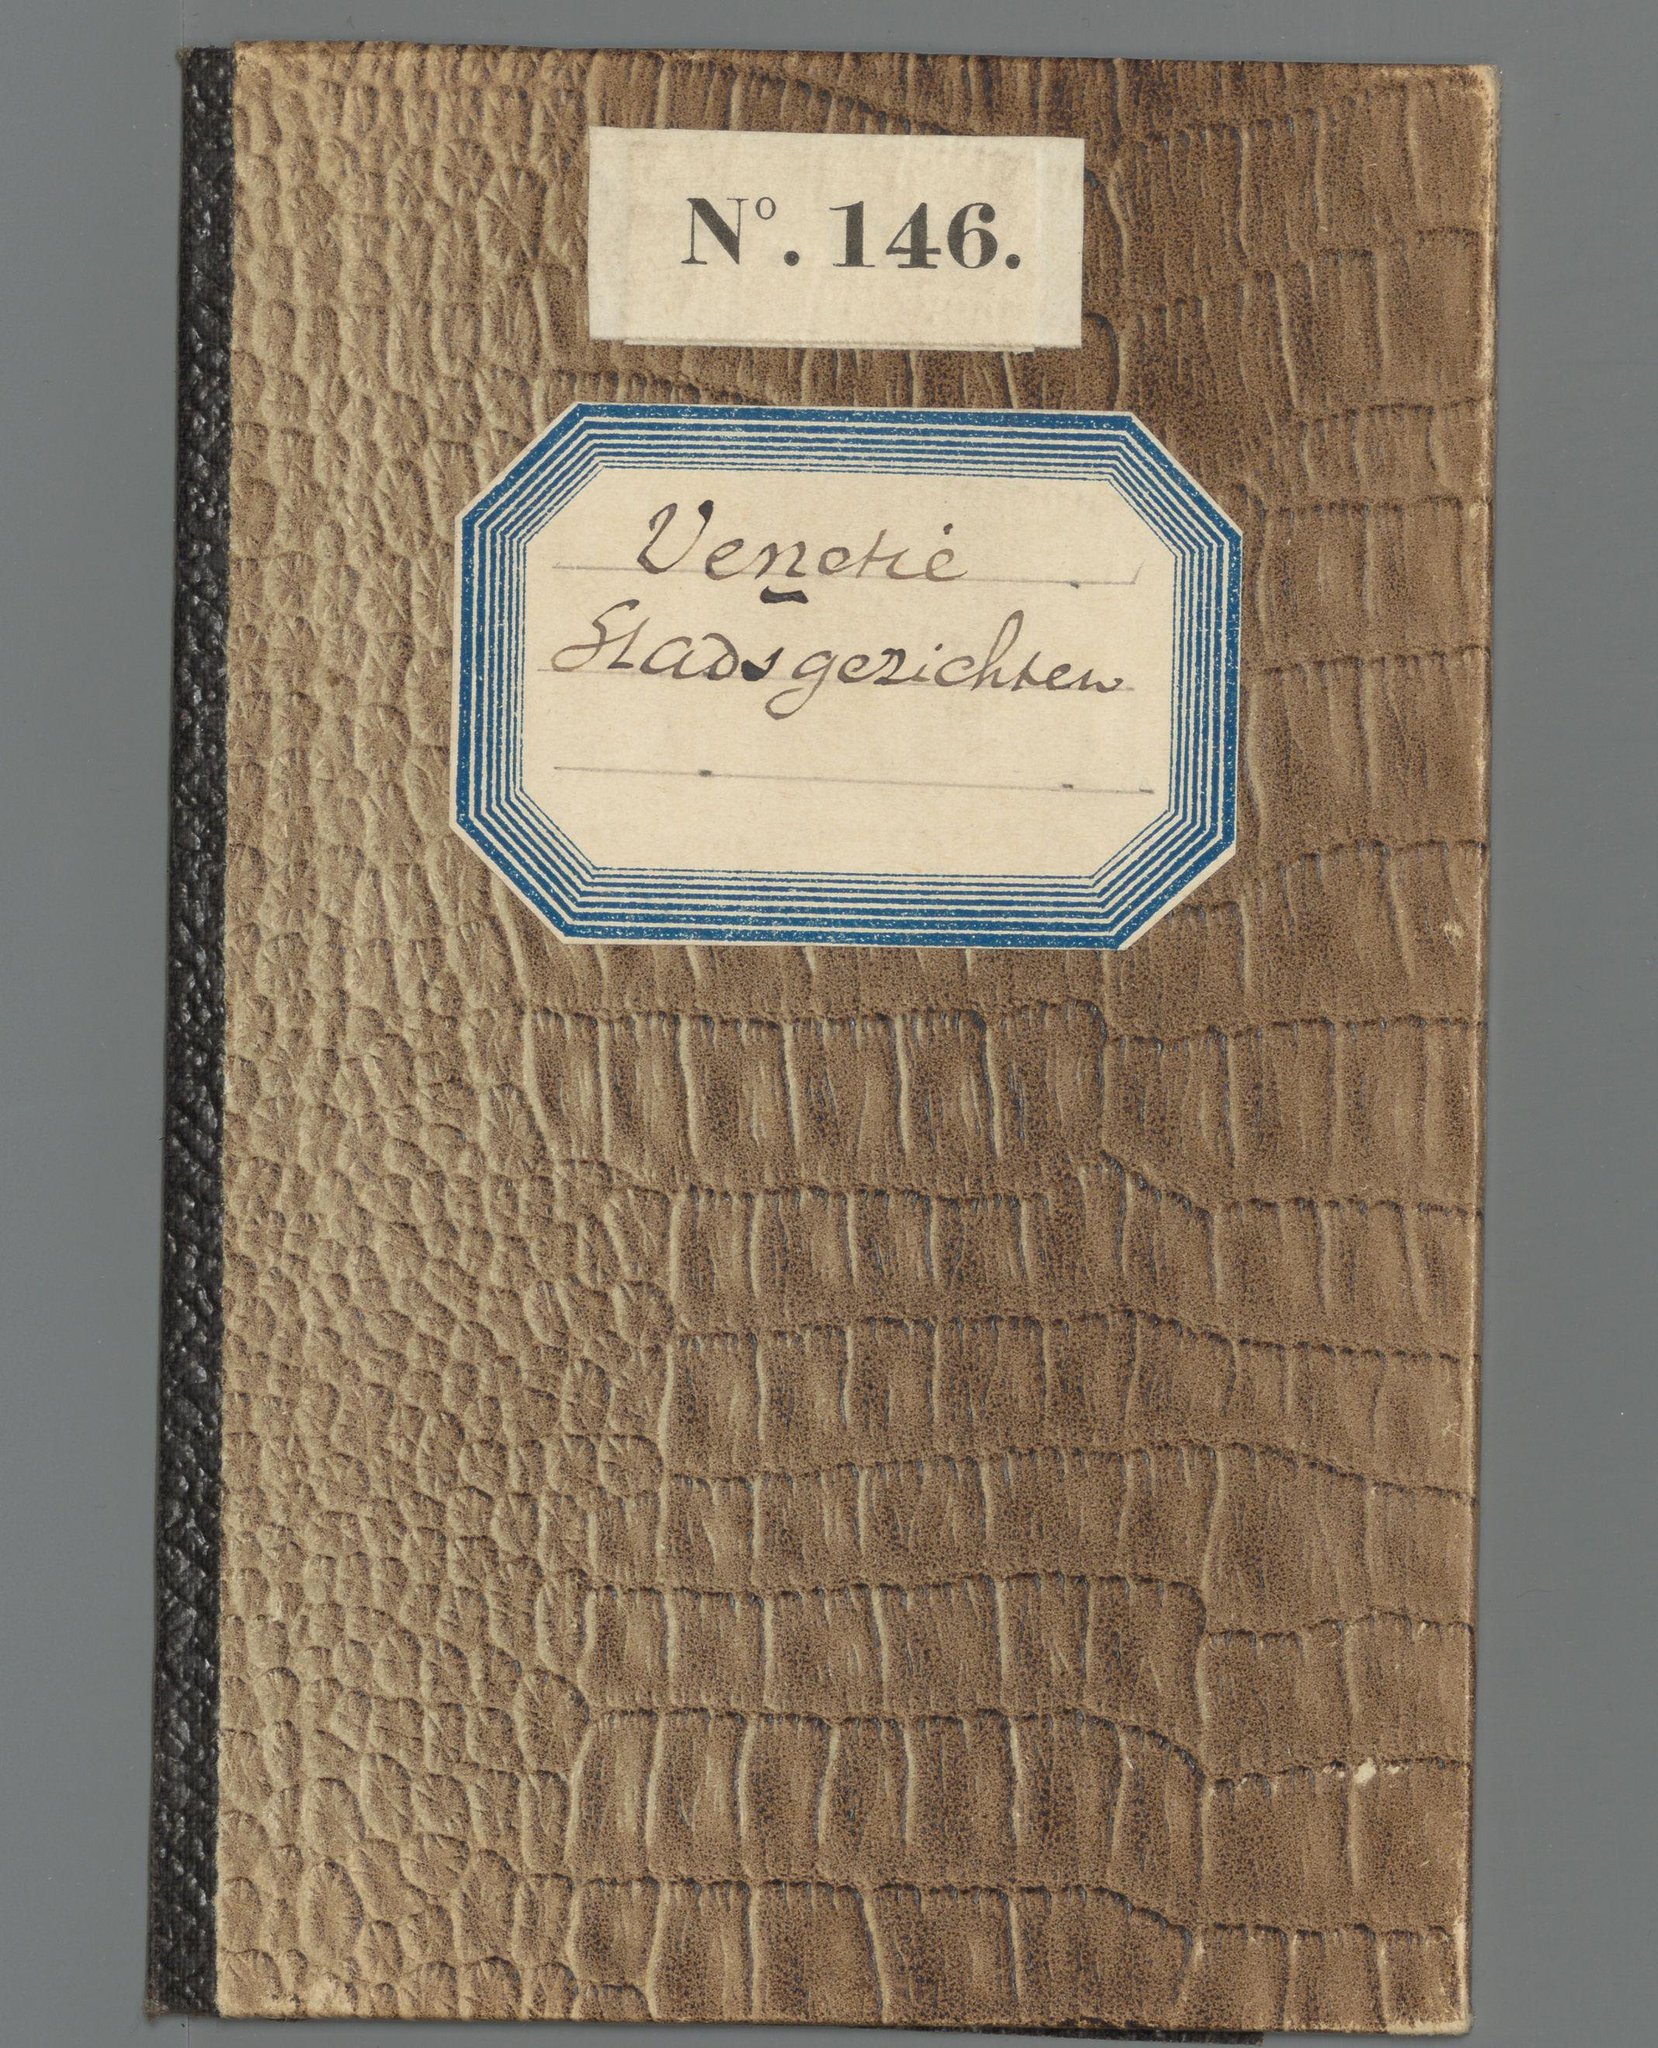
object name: wrapper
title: Venetië. Stadsgezichten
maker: Anonymous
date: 1900-1950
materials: cardboard, ink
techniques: pen